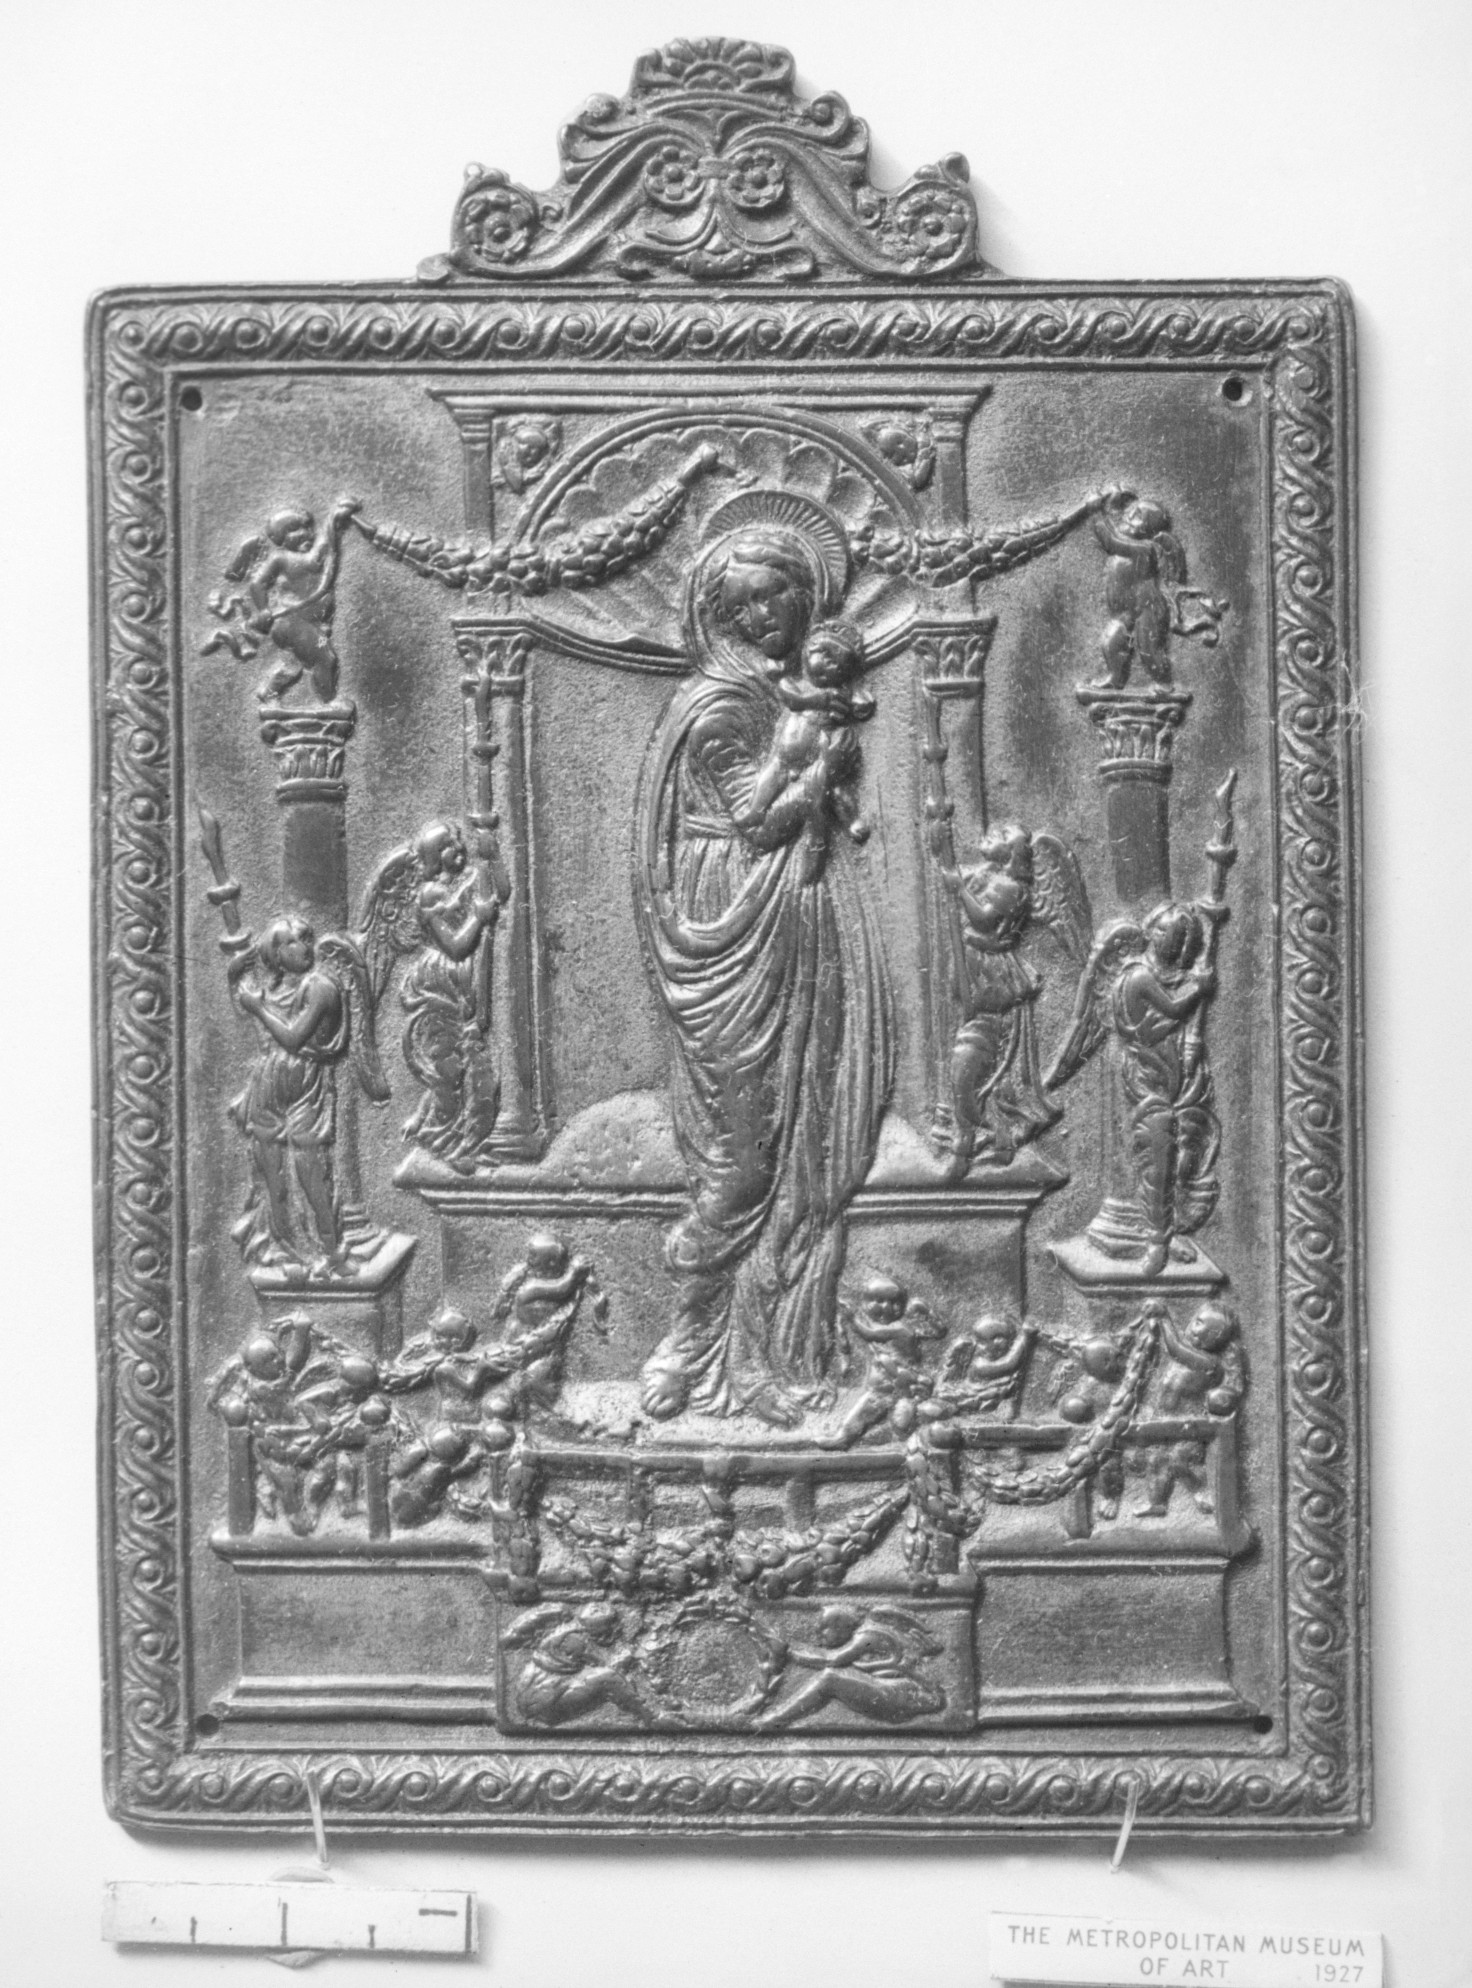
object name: plaquette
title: Virgin and Child with angels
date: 1467-1500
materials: bronze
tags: infants,angels,virgin mary